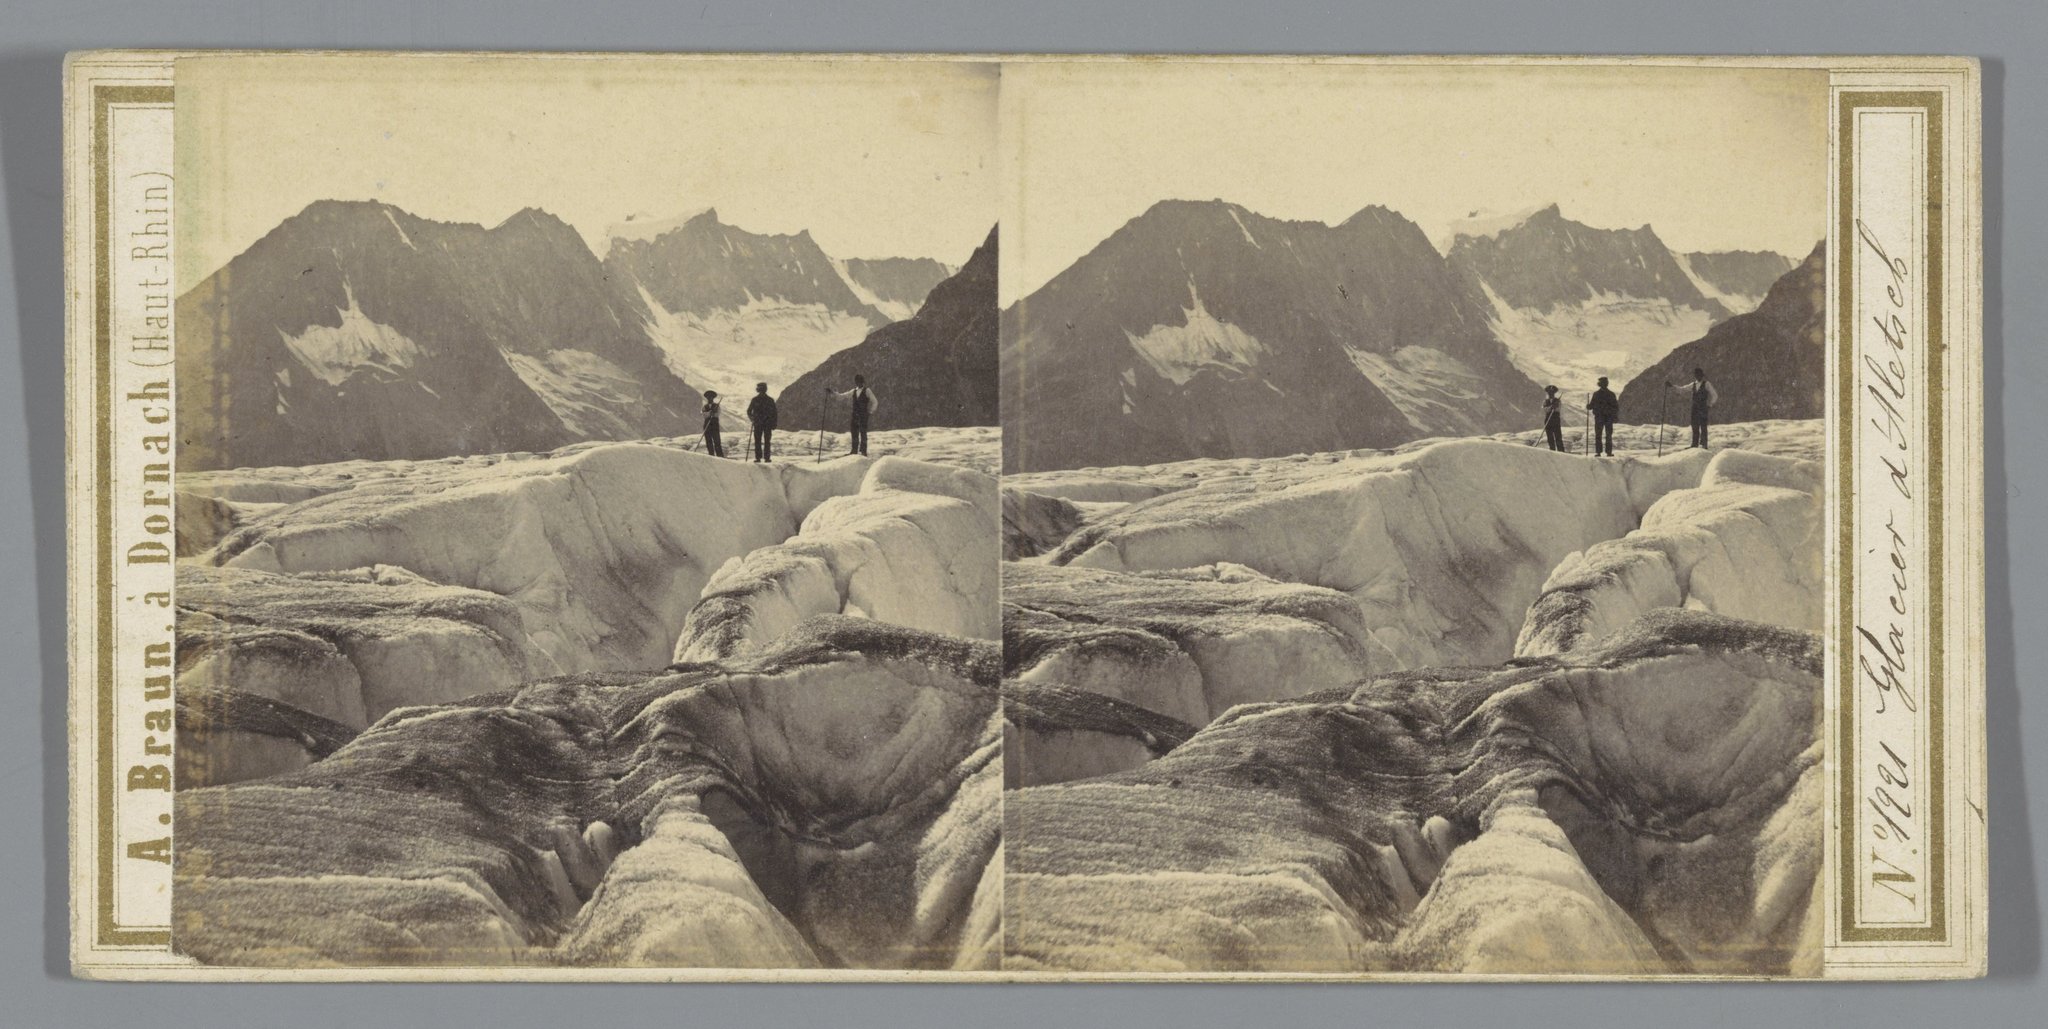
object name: stereograph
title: Glacier d'Aletsch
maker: Anonymous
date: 1860-1866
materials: cardboard, paper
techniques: albumen print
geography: dornach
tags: mountain climbing, mountaineering, glacier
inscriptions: number: ‘No. 1221’